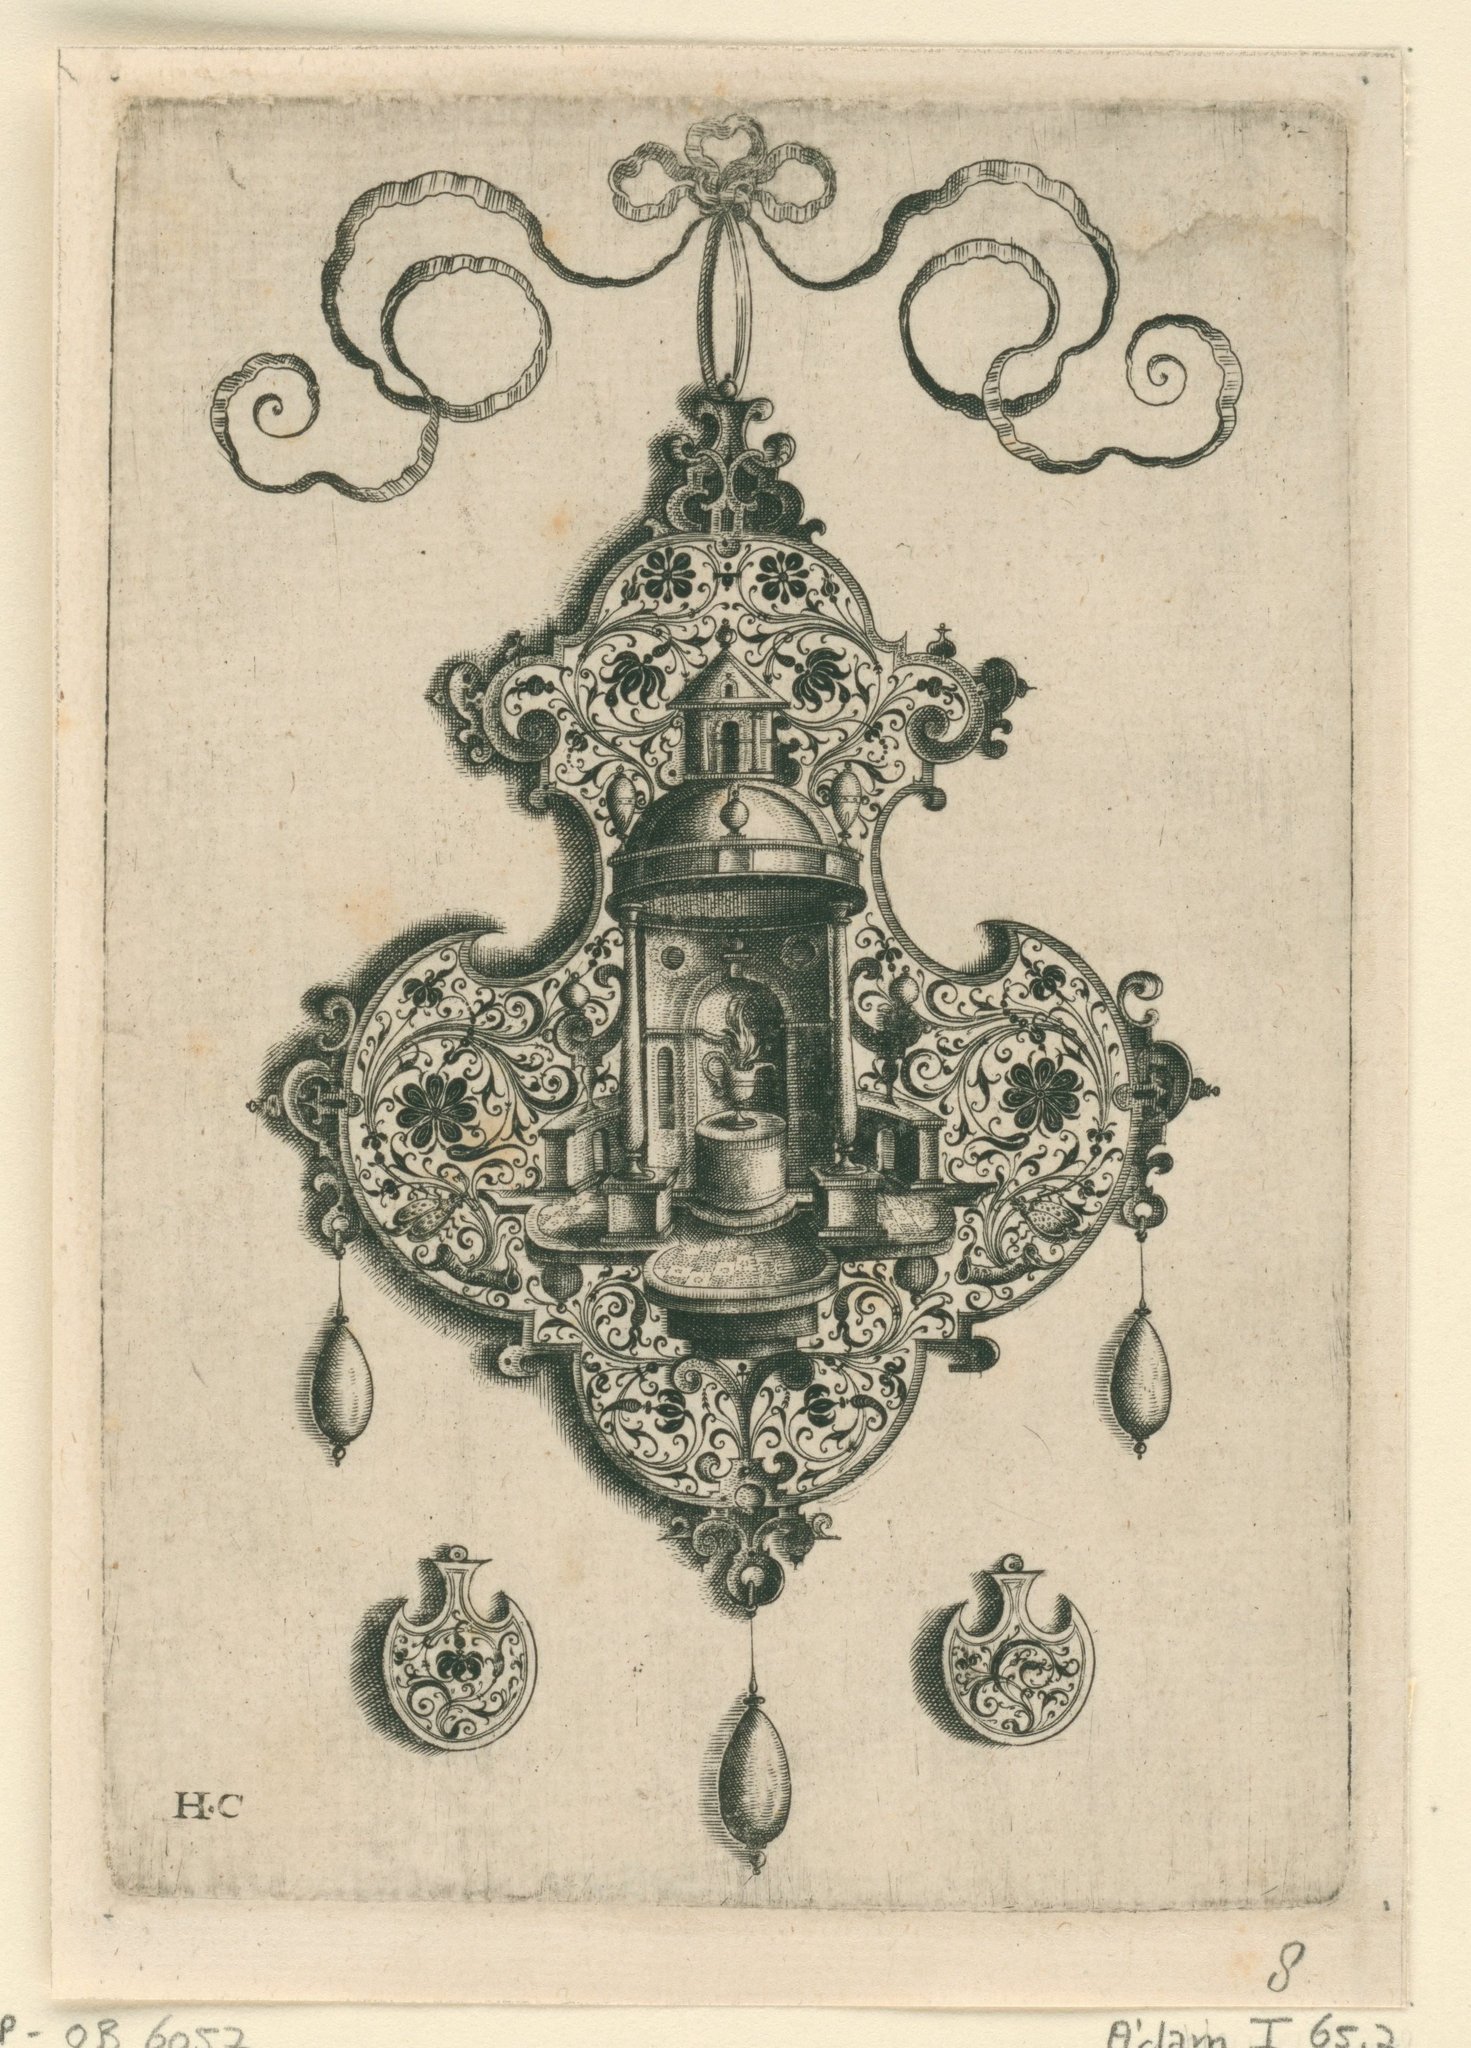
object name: ornament print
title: Hangers met arabesken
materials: paper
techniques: engraving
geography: netherlands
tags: pendant, trinket, 'breloque'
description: Voor zijde voor een hanger. In het midden staat een overkoepelde nis met een torentje. In de nis staat op een verhoging een kan waar een vlam uitkomt. Linksonder en rechtsonder een bijna ovaal kostuumornament. Een van 9 bladen afkomstig uit een serie van 10 bladen met hangers. Aan iedere hanger hangen drie parels. Op elk blad bovendien nog twee of vier kleine kostuumornamenten.